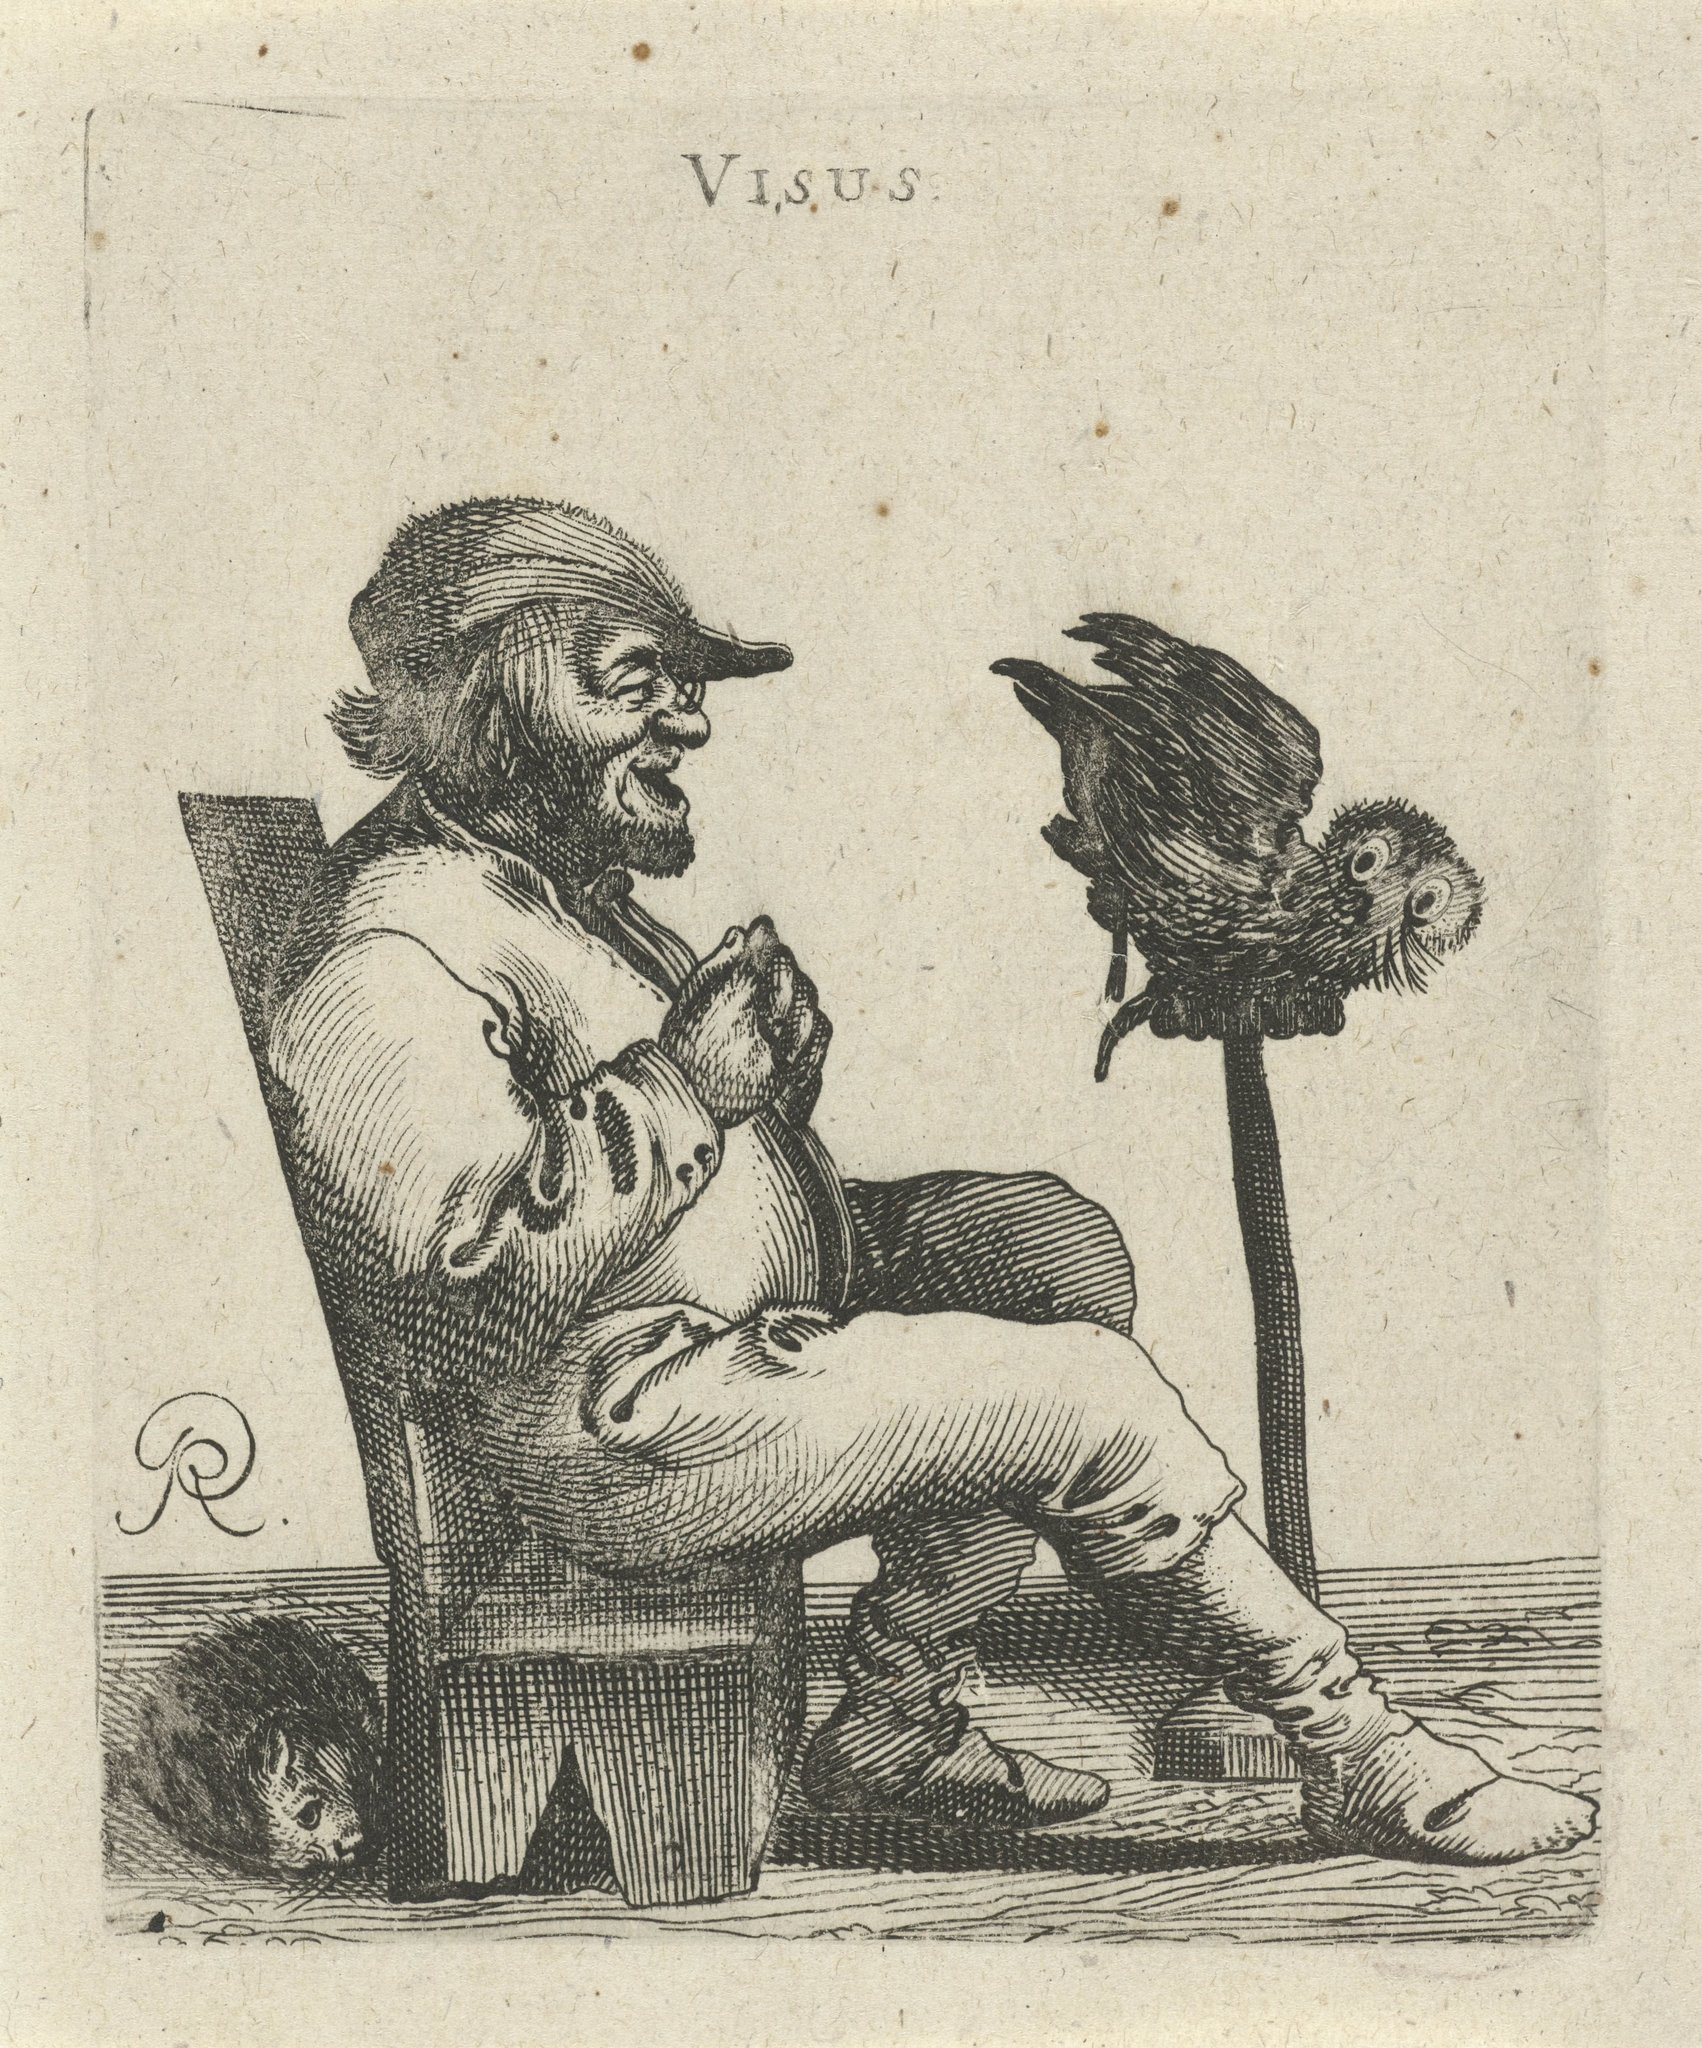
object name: print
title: De vijf zintuigen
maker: pieter jansz quast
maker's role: draughtsman, painter, print maker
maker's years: 1605-1647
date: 1638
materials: paper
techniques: engraving, etching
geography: the hague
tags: eyeglasses, spectacles, cat, sight, looking (one of the five senses), birds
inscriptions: collector's mark: Lugt 240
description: Op een stoel zit een man met een bril op zijn neus naar een uil te kijken, die voor hem op een stok zit. Achter de stoel heeft een kat zich verscholen. De prent maakt deel uit van een serie van zes prenten met de vijf zintuigen.